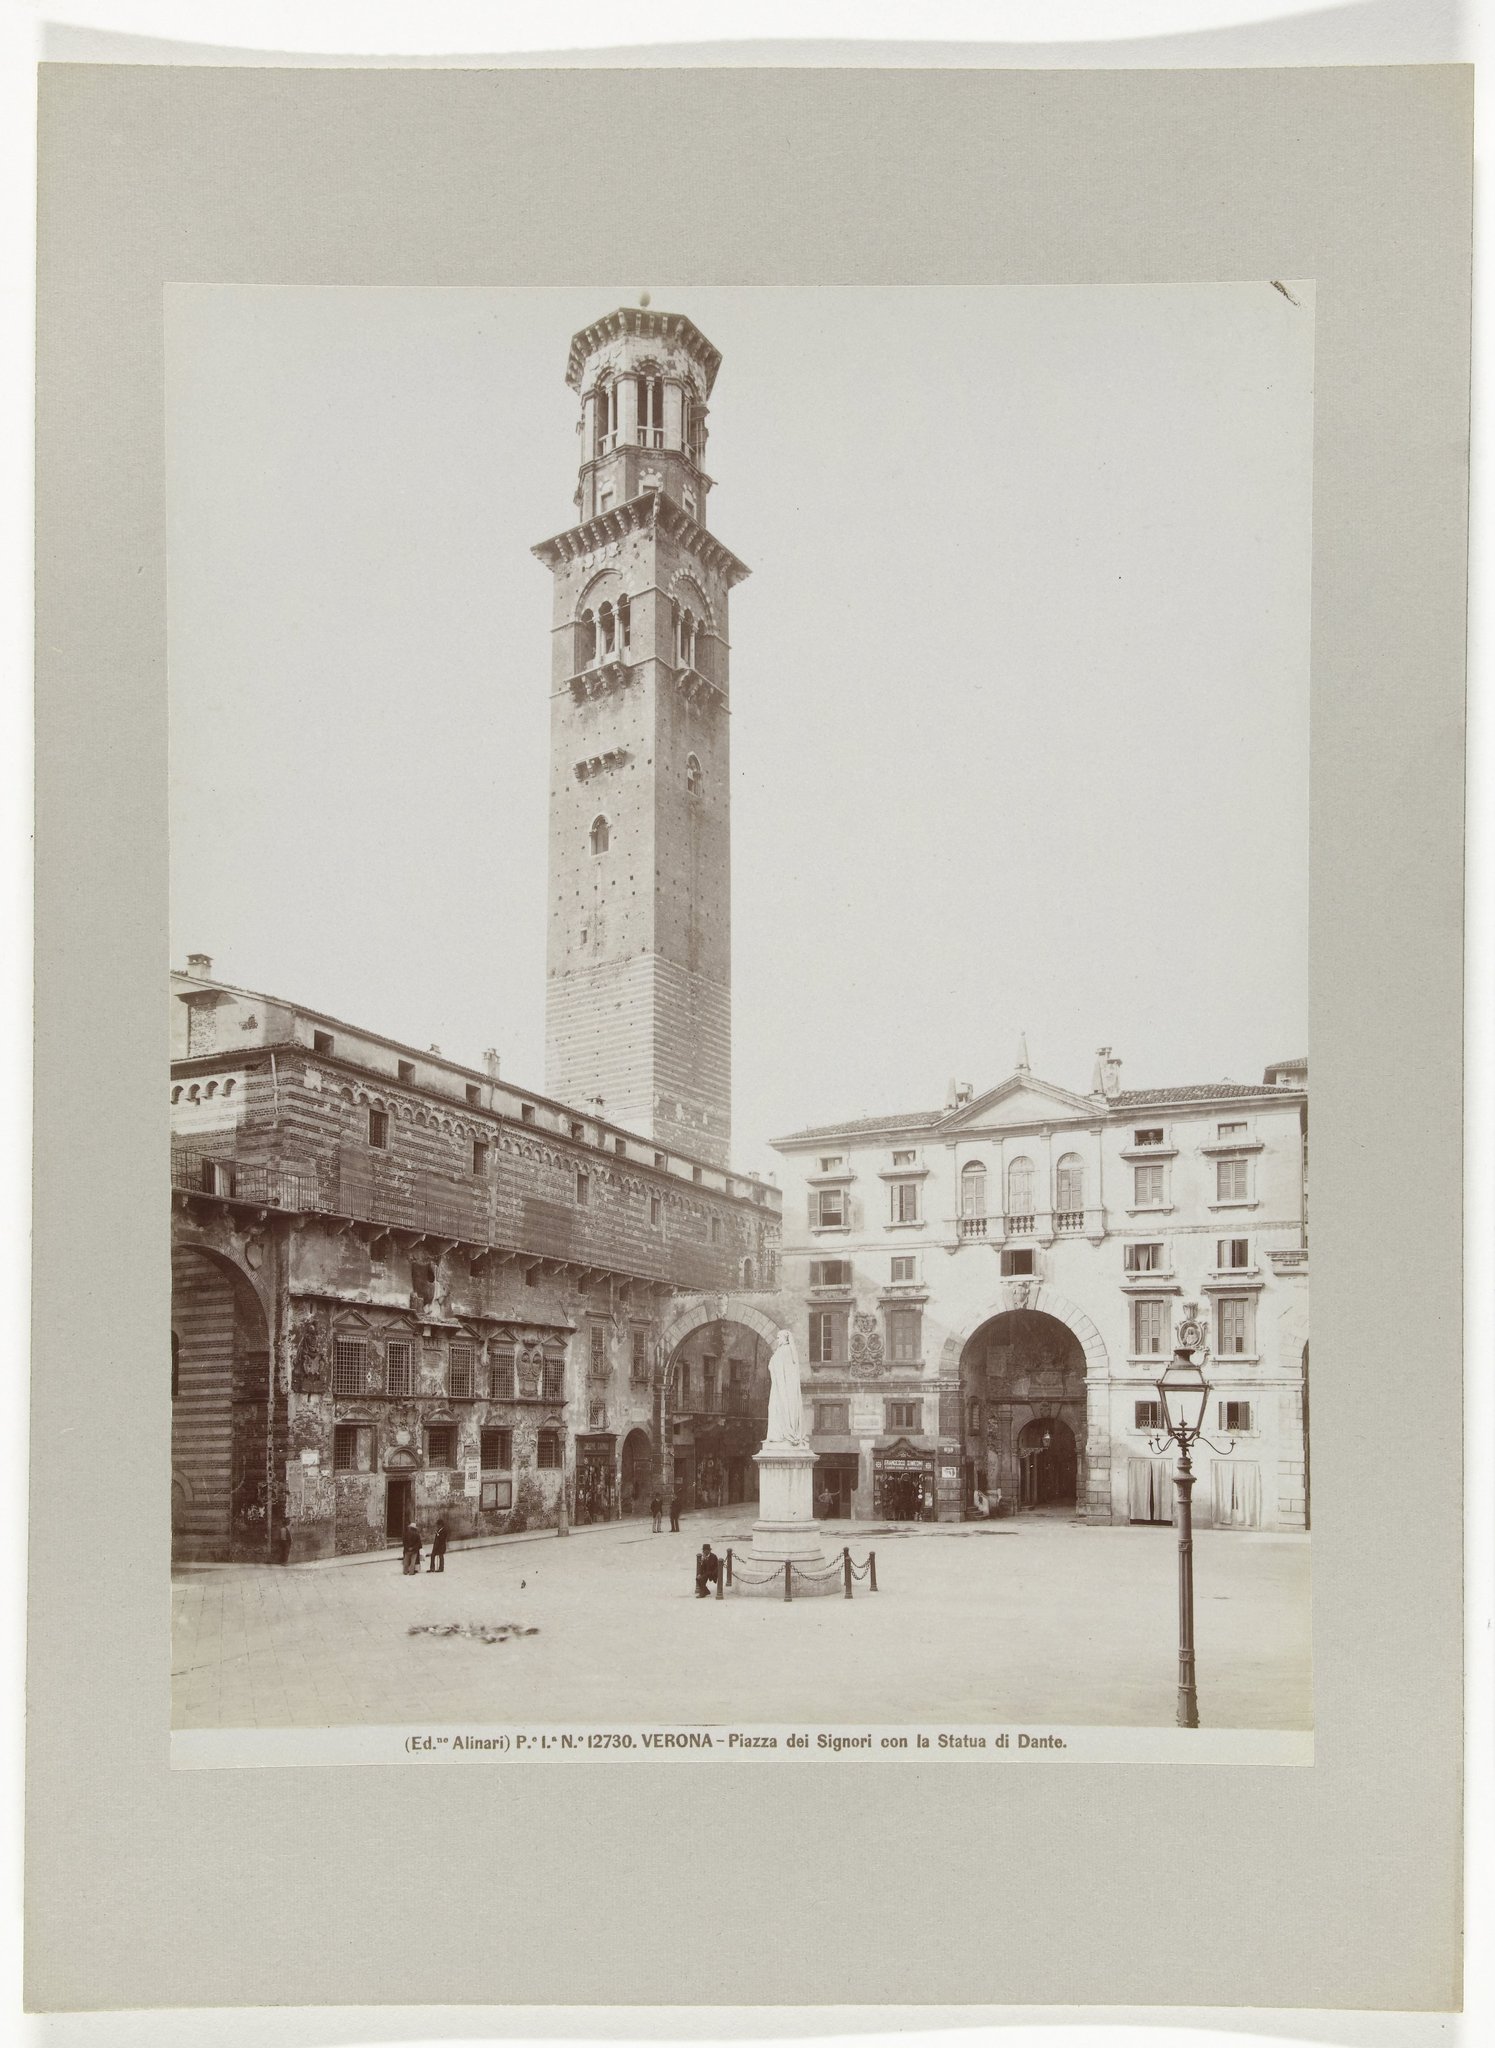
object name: photograph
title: P.e 1.a N.o 12730. VERONA - Piazza dei Signori con la Statua di Dante.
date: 1880-1895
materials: cardboard, paper, photographic support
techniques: albumen print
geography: florence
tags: square, place, circus, etc., piece of sculpture, reproduction of a piece of sculpture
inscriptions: number: ‘89.’